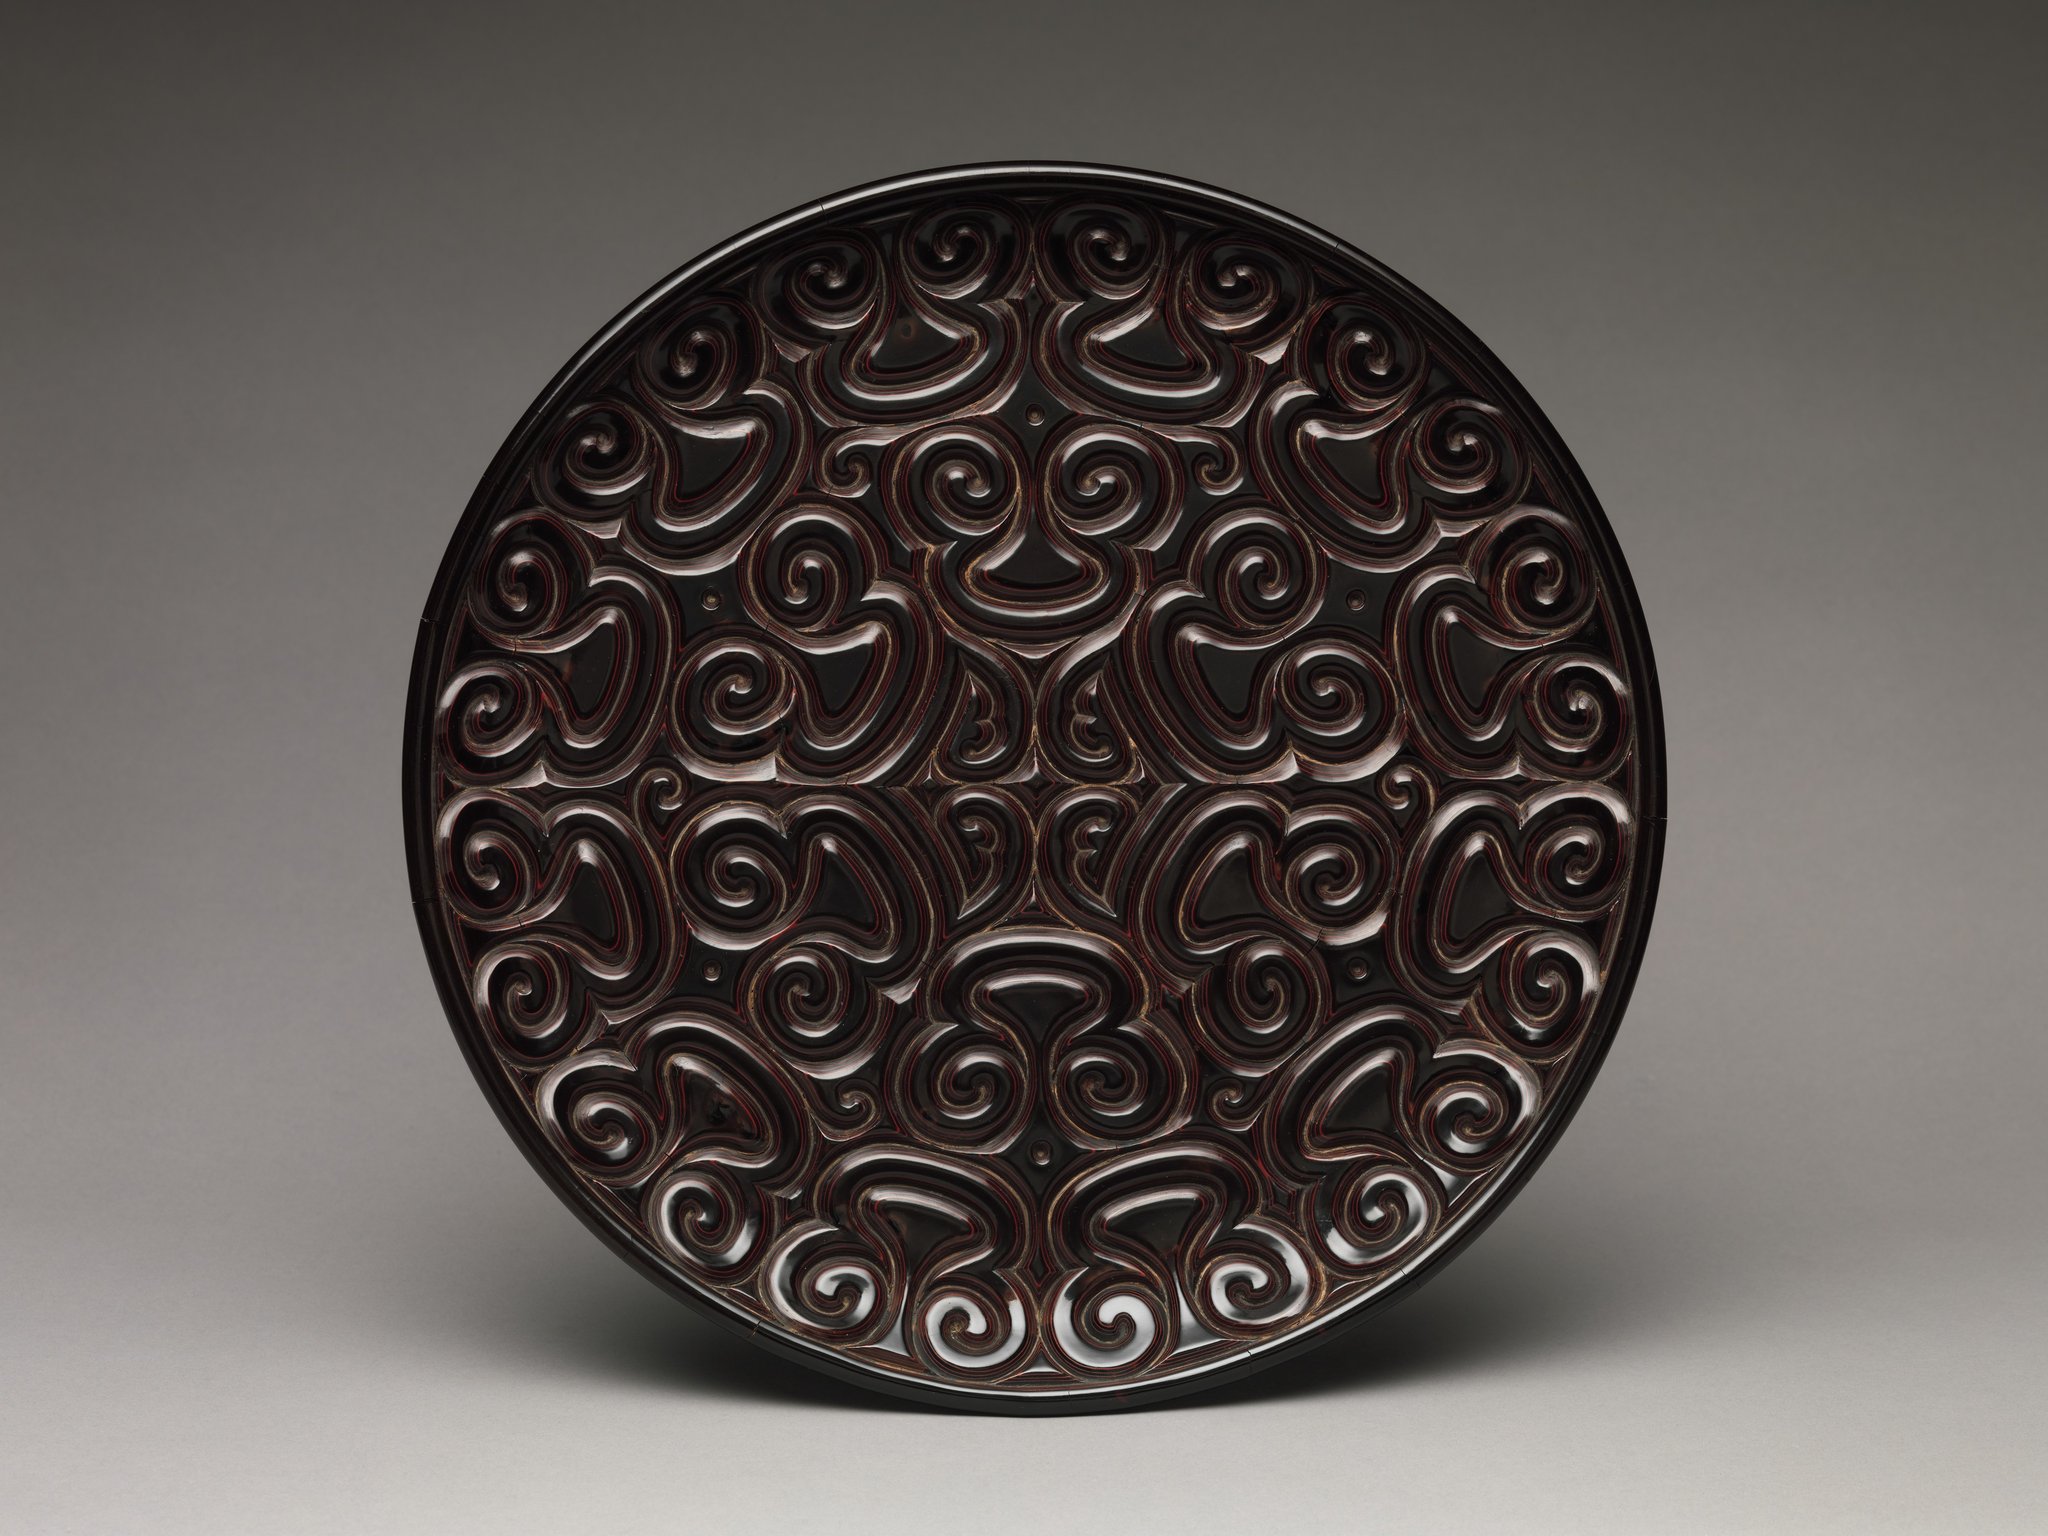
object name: dish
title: Dish with pommel scrolls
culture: chinese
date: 1351-1400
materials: lacquer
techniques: carving